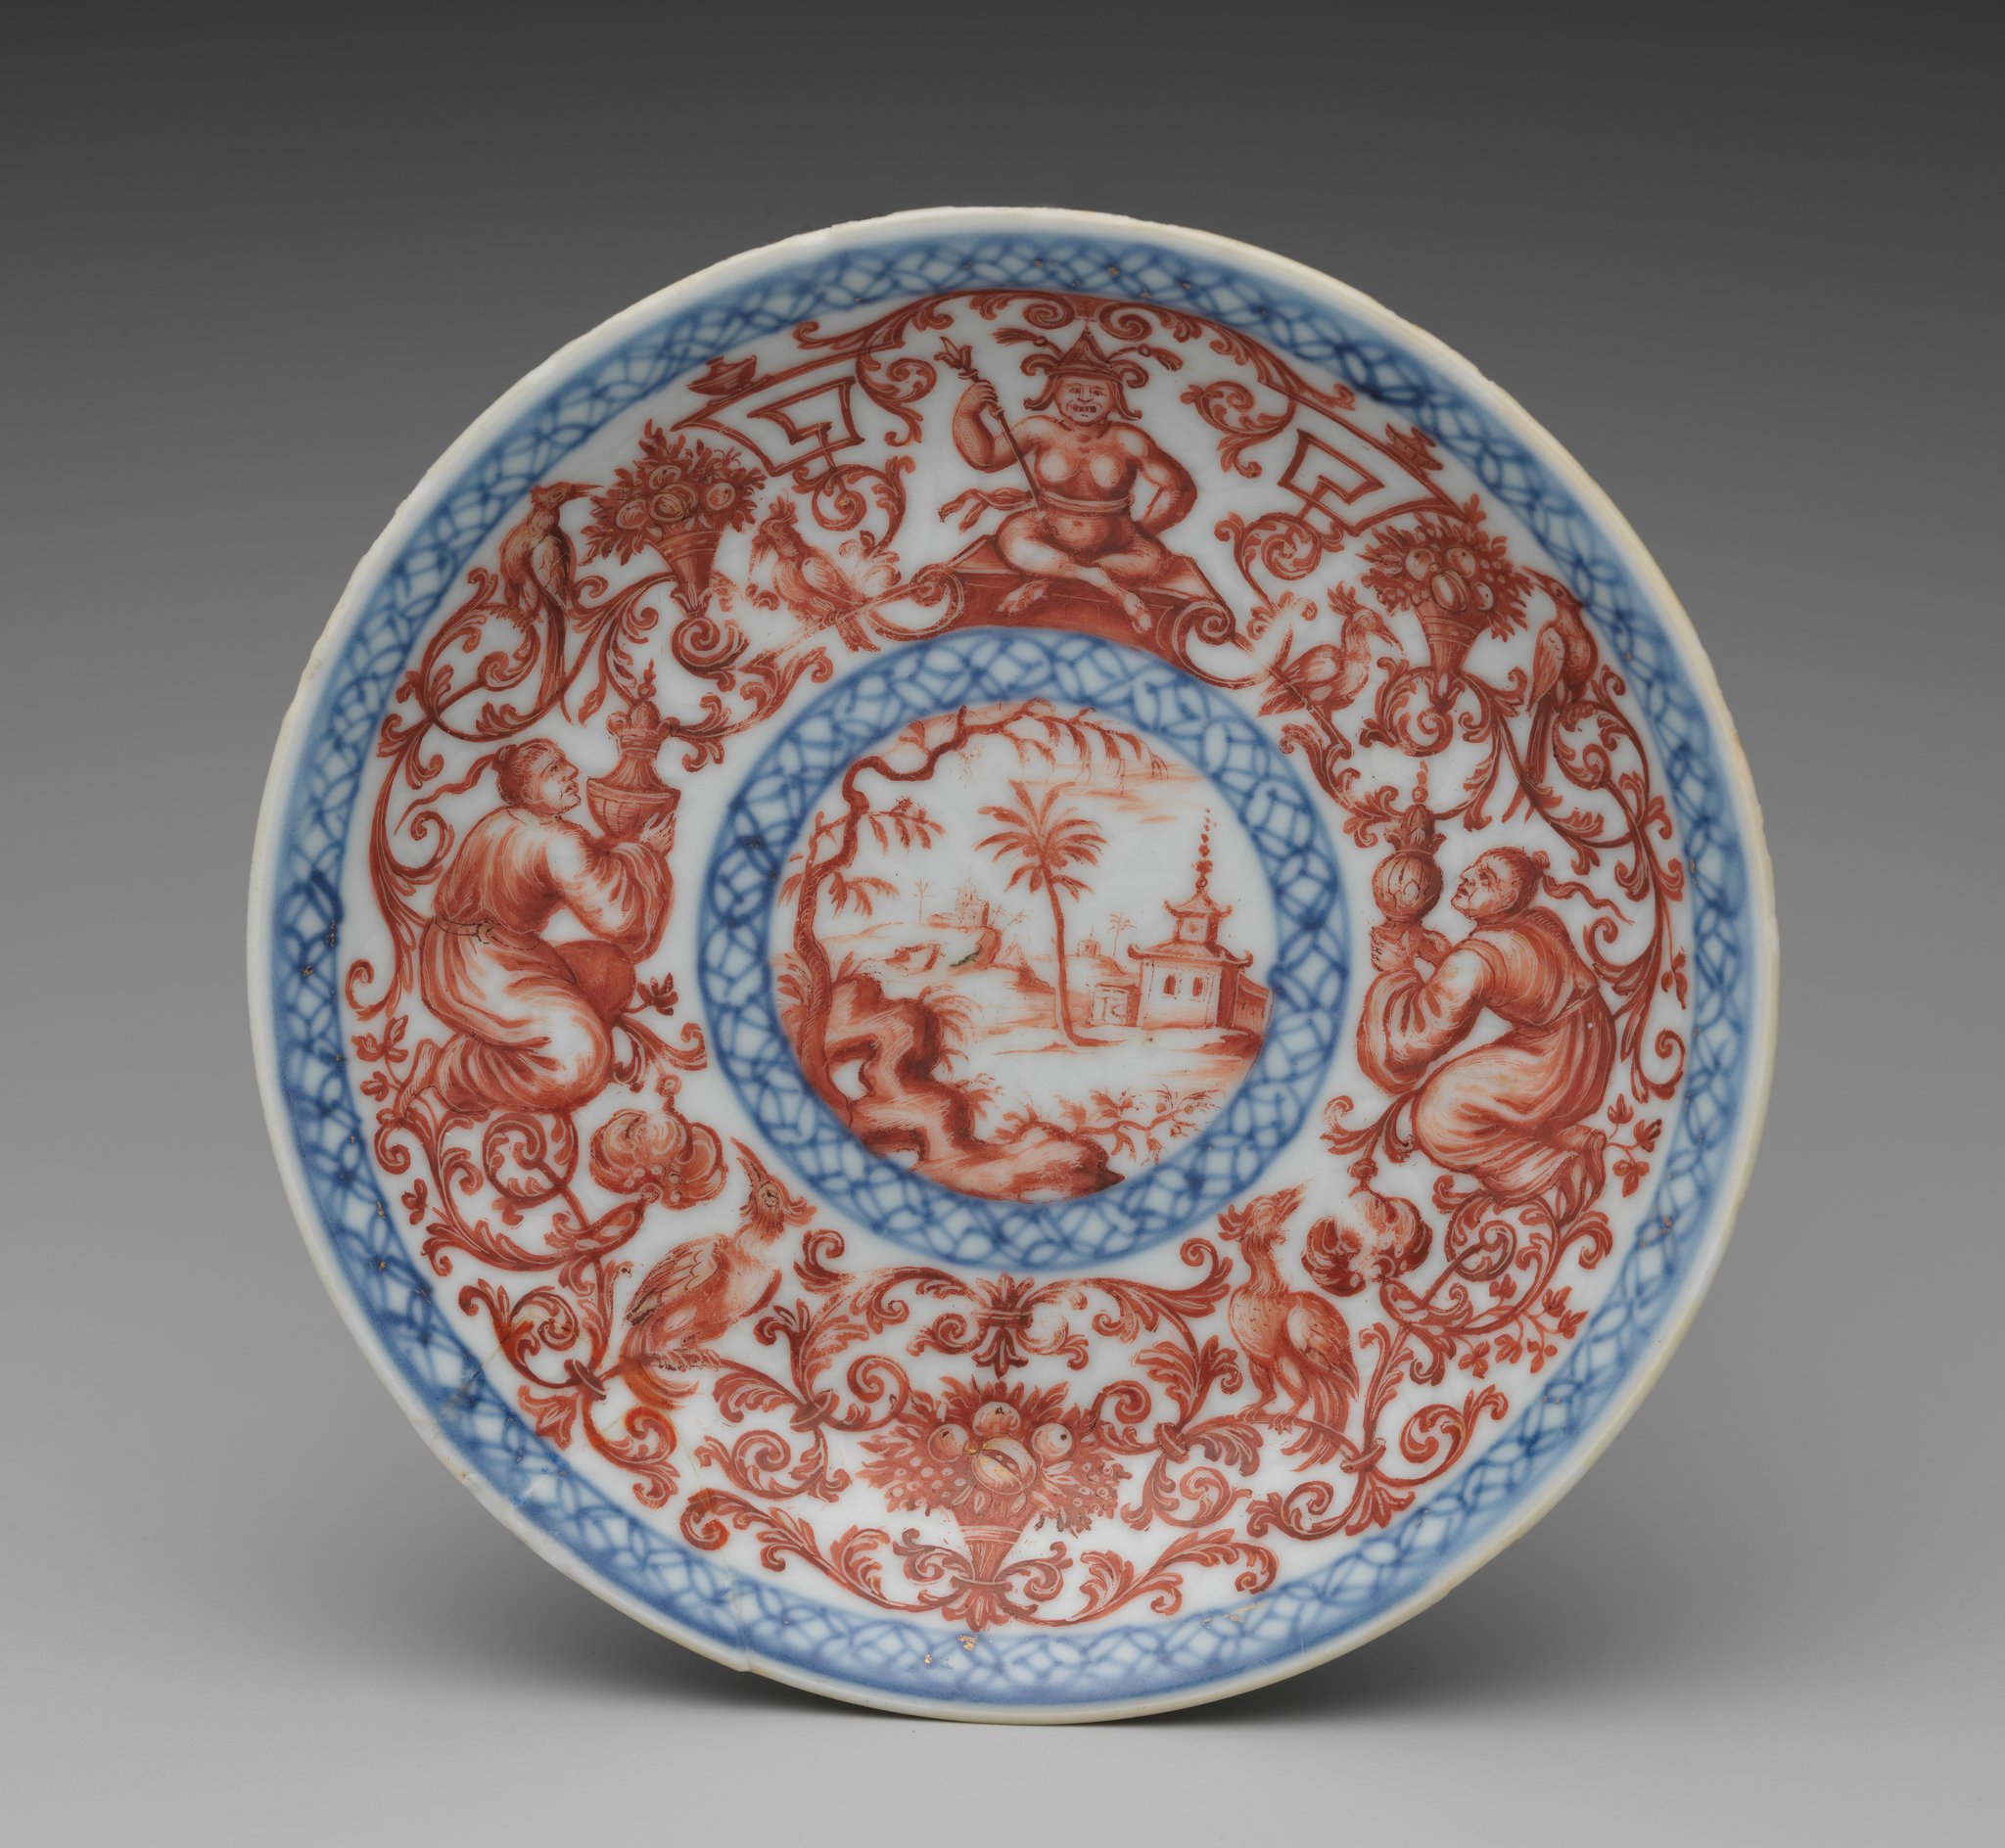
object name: saucer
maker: ignaz preissler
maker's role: decorator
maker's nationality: bohemian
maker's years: 1676-1741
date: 1730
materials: hard paste porcelain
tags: birds,men,female nudes